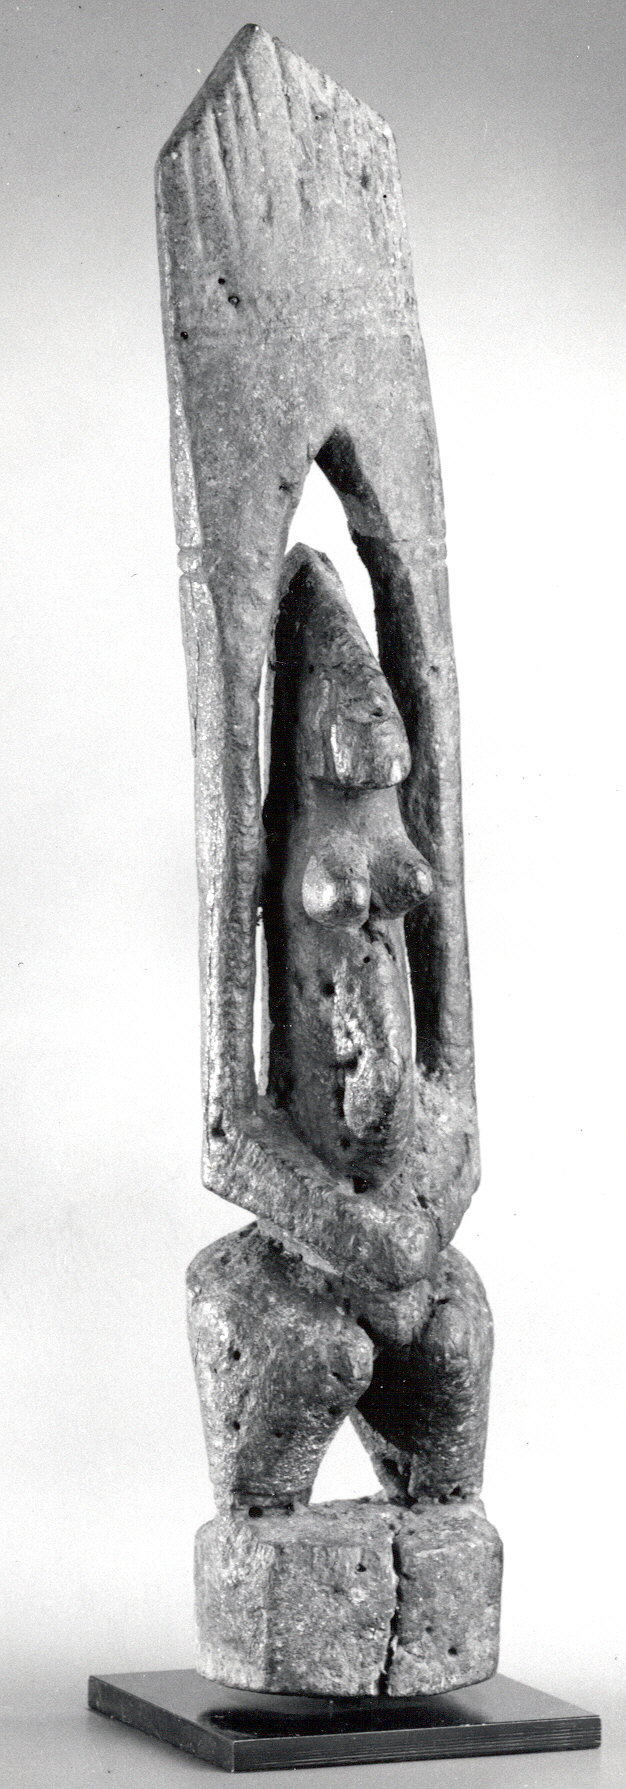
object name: figure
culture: dogon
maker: dogon blacksmith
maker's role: artist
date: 1501-1900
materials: patina, wood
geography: mali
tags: women